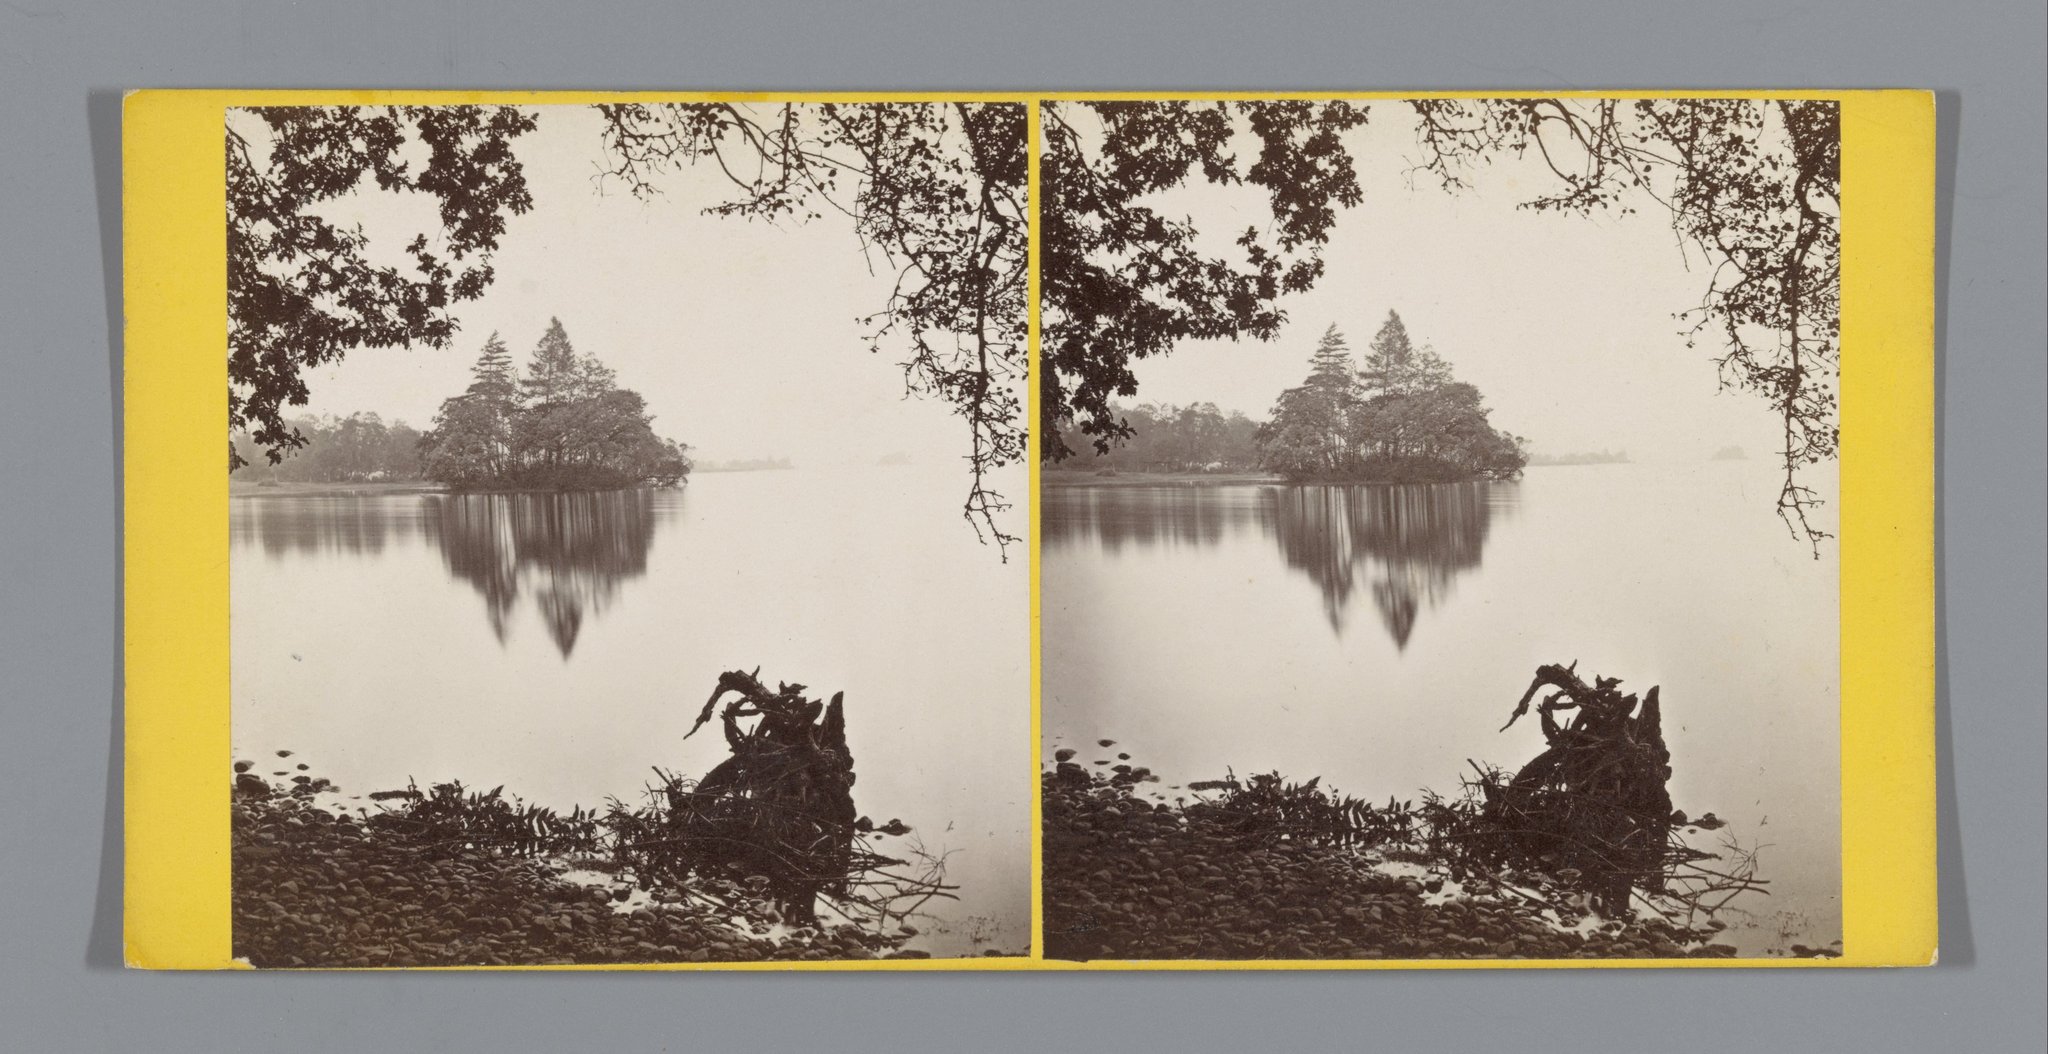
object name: stereograph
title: Gezicht op Swan Island in Loch Lomond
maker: george washington wilson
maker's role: publisher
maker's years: 1823-1893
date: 1858-1872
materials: cardboard, photographic support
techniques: albumen print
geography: loch lomond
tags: island, lake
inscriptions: number: ‘No. 834.’